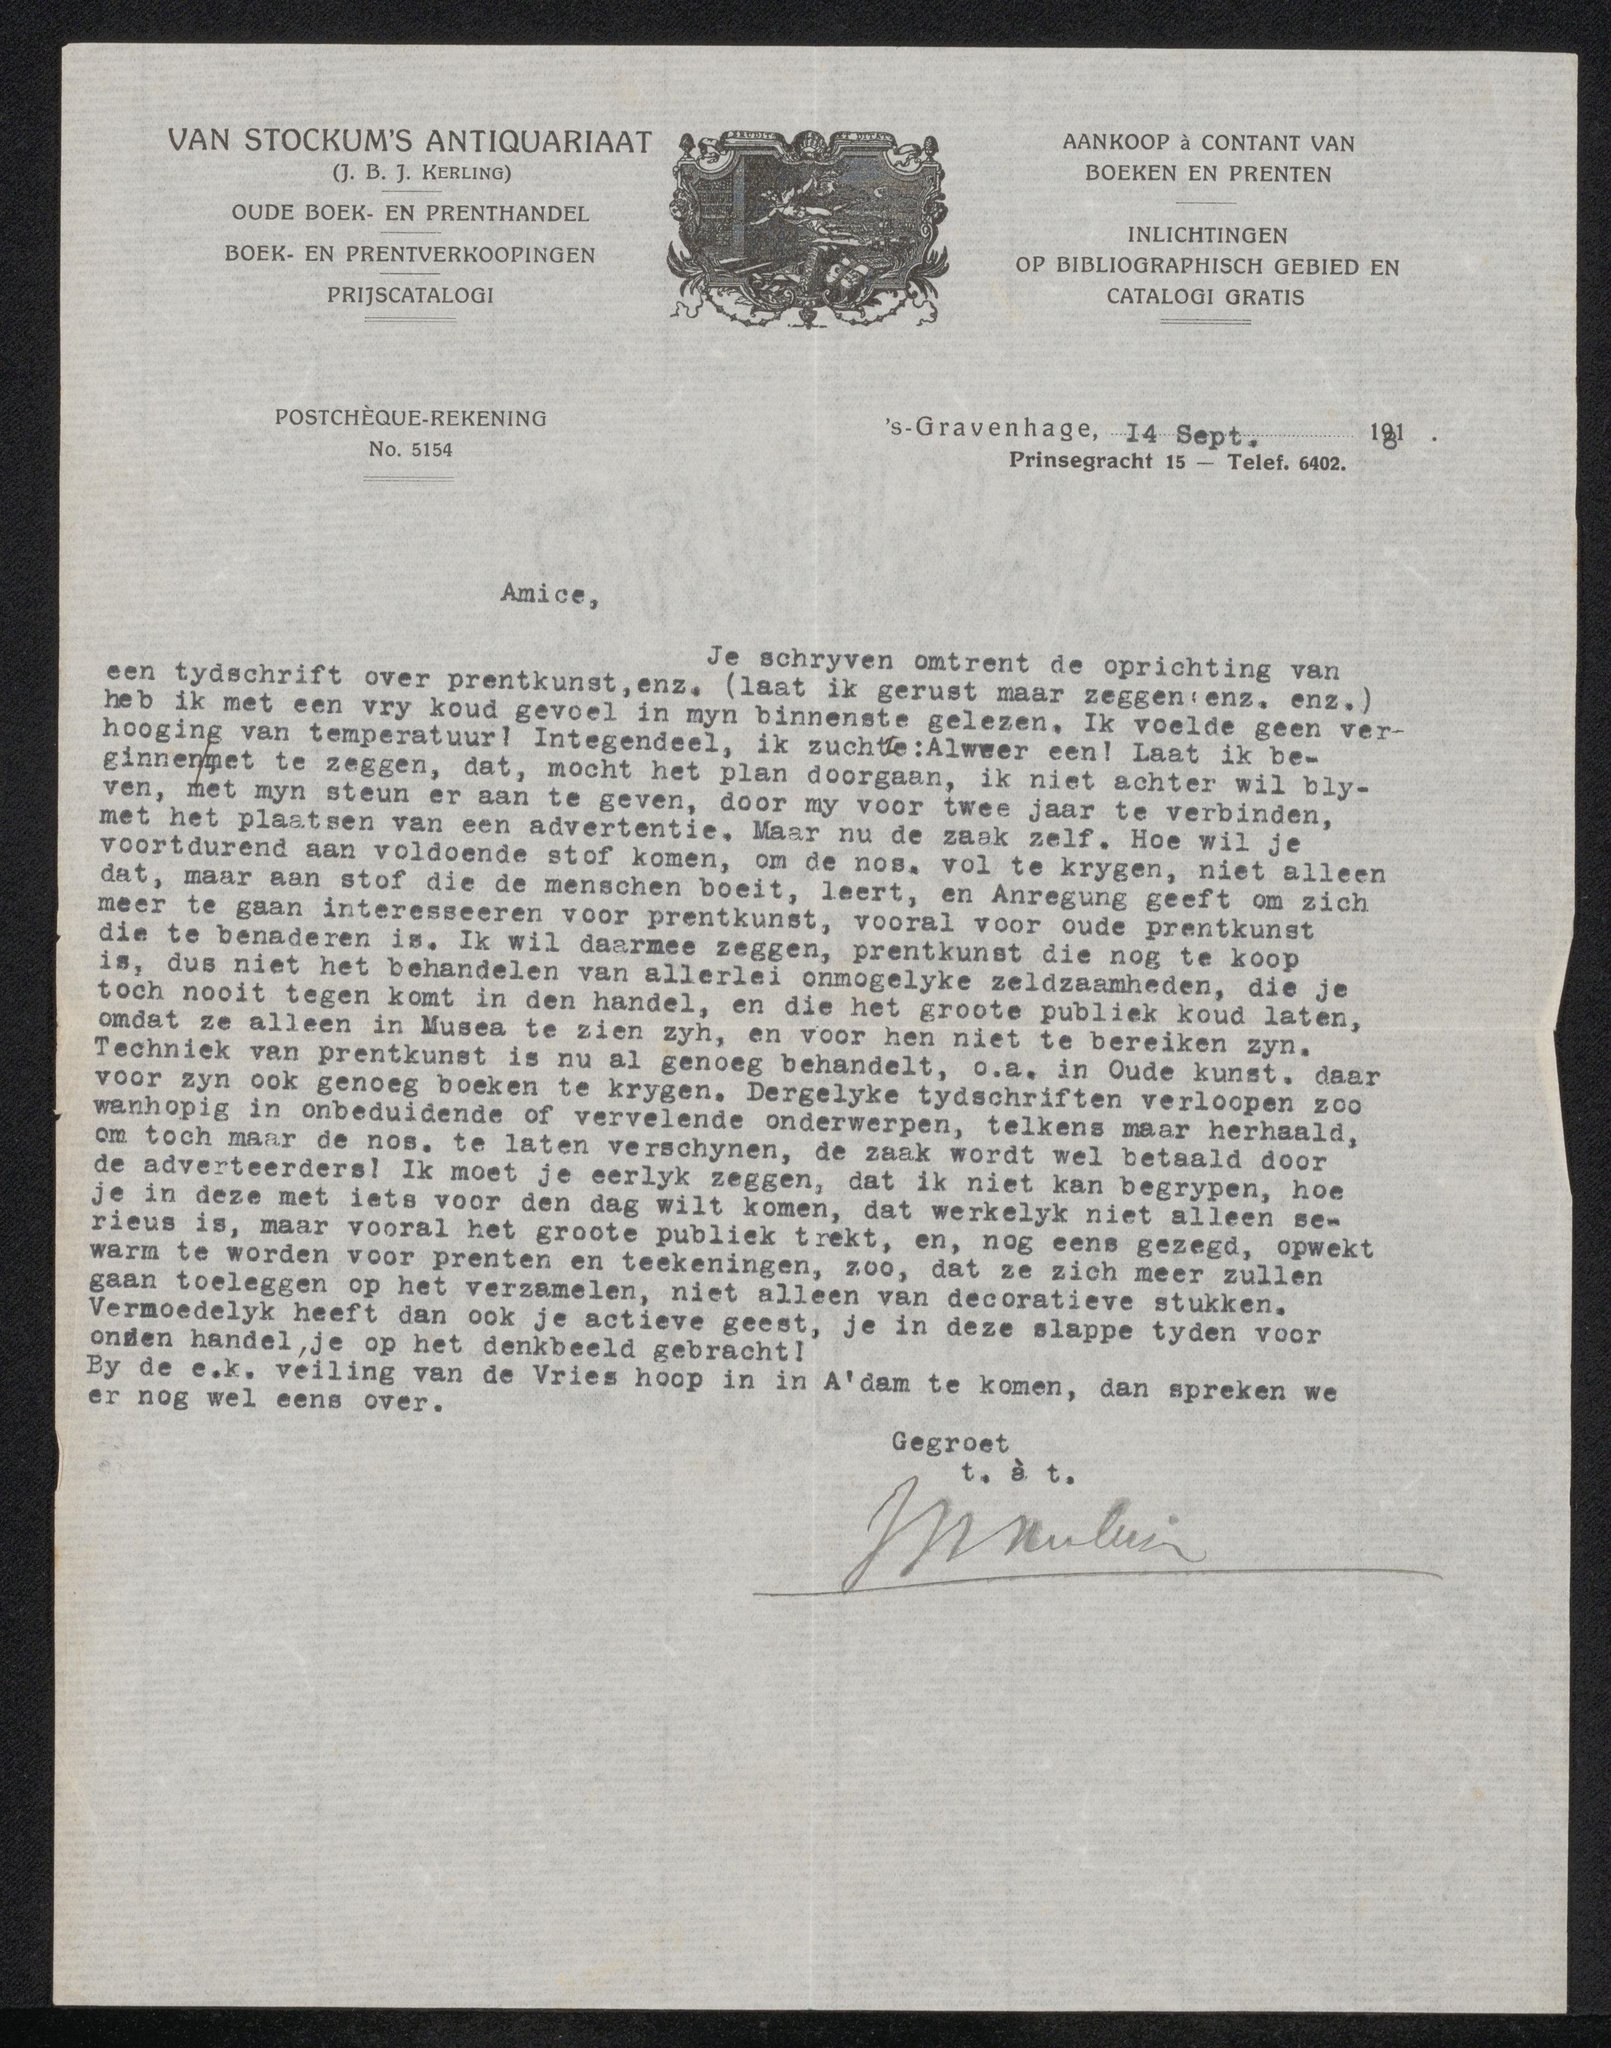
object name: letter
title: Brief aan Bernard Houthakker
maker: j.b.j. kerling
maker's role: kunsthandelaar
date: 1918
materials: ink, paper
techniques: pen, printing, typewriting, writing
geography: the hague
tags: bernard houthakker, art trade, art shop, the graphic arts, printed matter, amsterdam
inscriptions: collector's mark: Lugt 2228